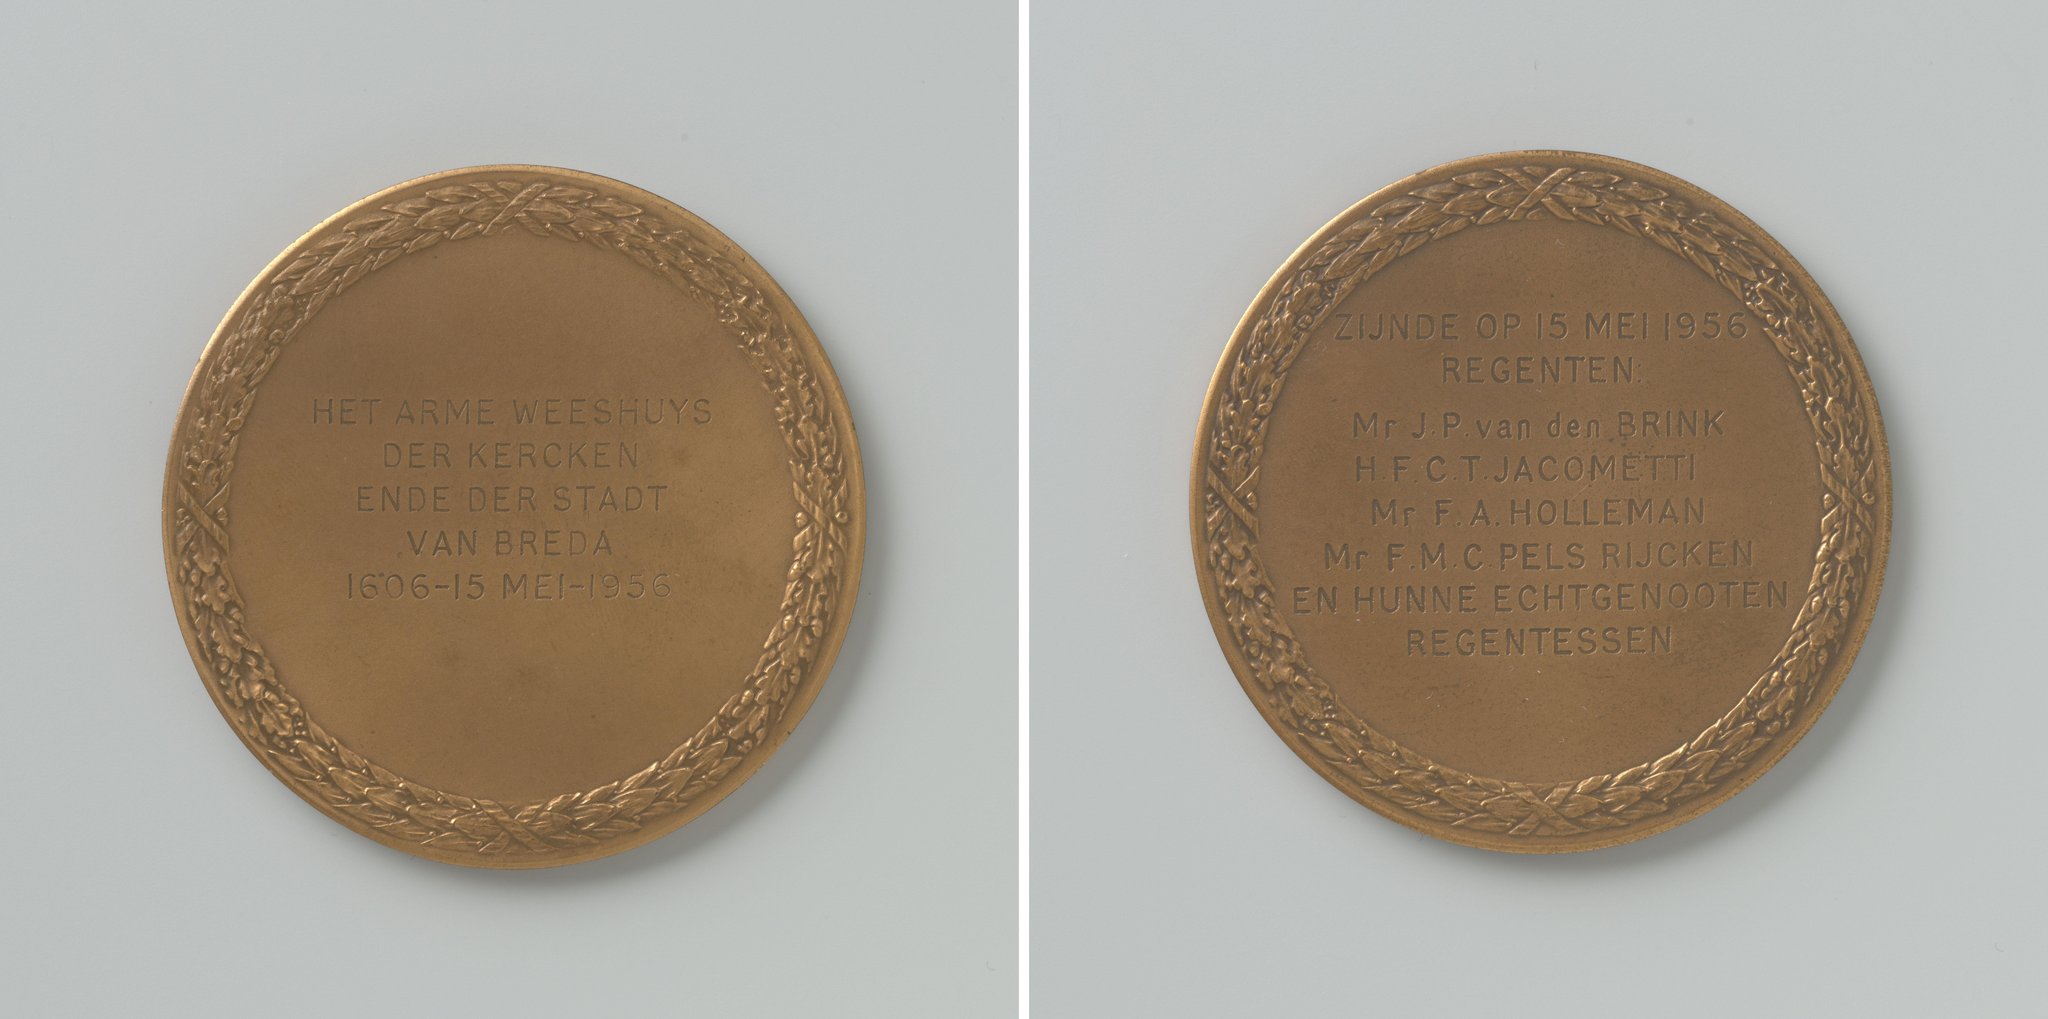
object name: medal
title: 350 years orphanage of Breda; the 'Arme Weeshuys der Kercken ende der Stadt Breda'.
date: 1956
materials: bronze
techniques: striking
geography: utrecht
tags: batavia, the hague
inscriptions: inscription: ‘ZIJNDE OP 15 MEI 1956 / REGENTEN / Mr J . P . van den BRINK / H . F . C . T . JACOMETTI / Mr F . A . HOLLEMAN / Mr F . M . C . PELS RIJCKEN / EN HUNNE ECHTGENOOTEN / REGENTESSEN’, inscription: ‘HET ARME WEESHUYS / DER KERCKEN / ENDE DER STADT / VAN BREDA / 1606 - 15 MEI - 1956’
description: op beide zijden een gegraveerde tekst in een rand van bijeengebonden bladeren